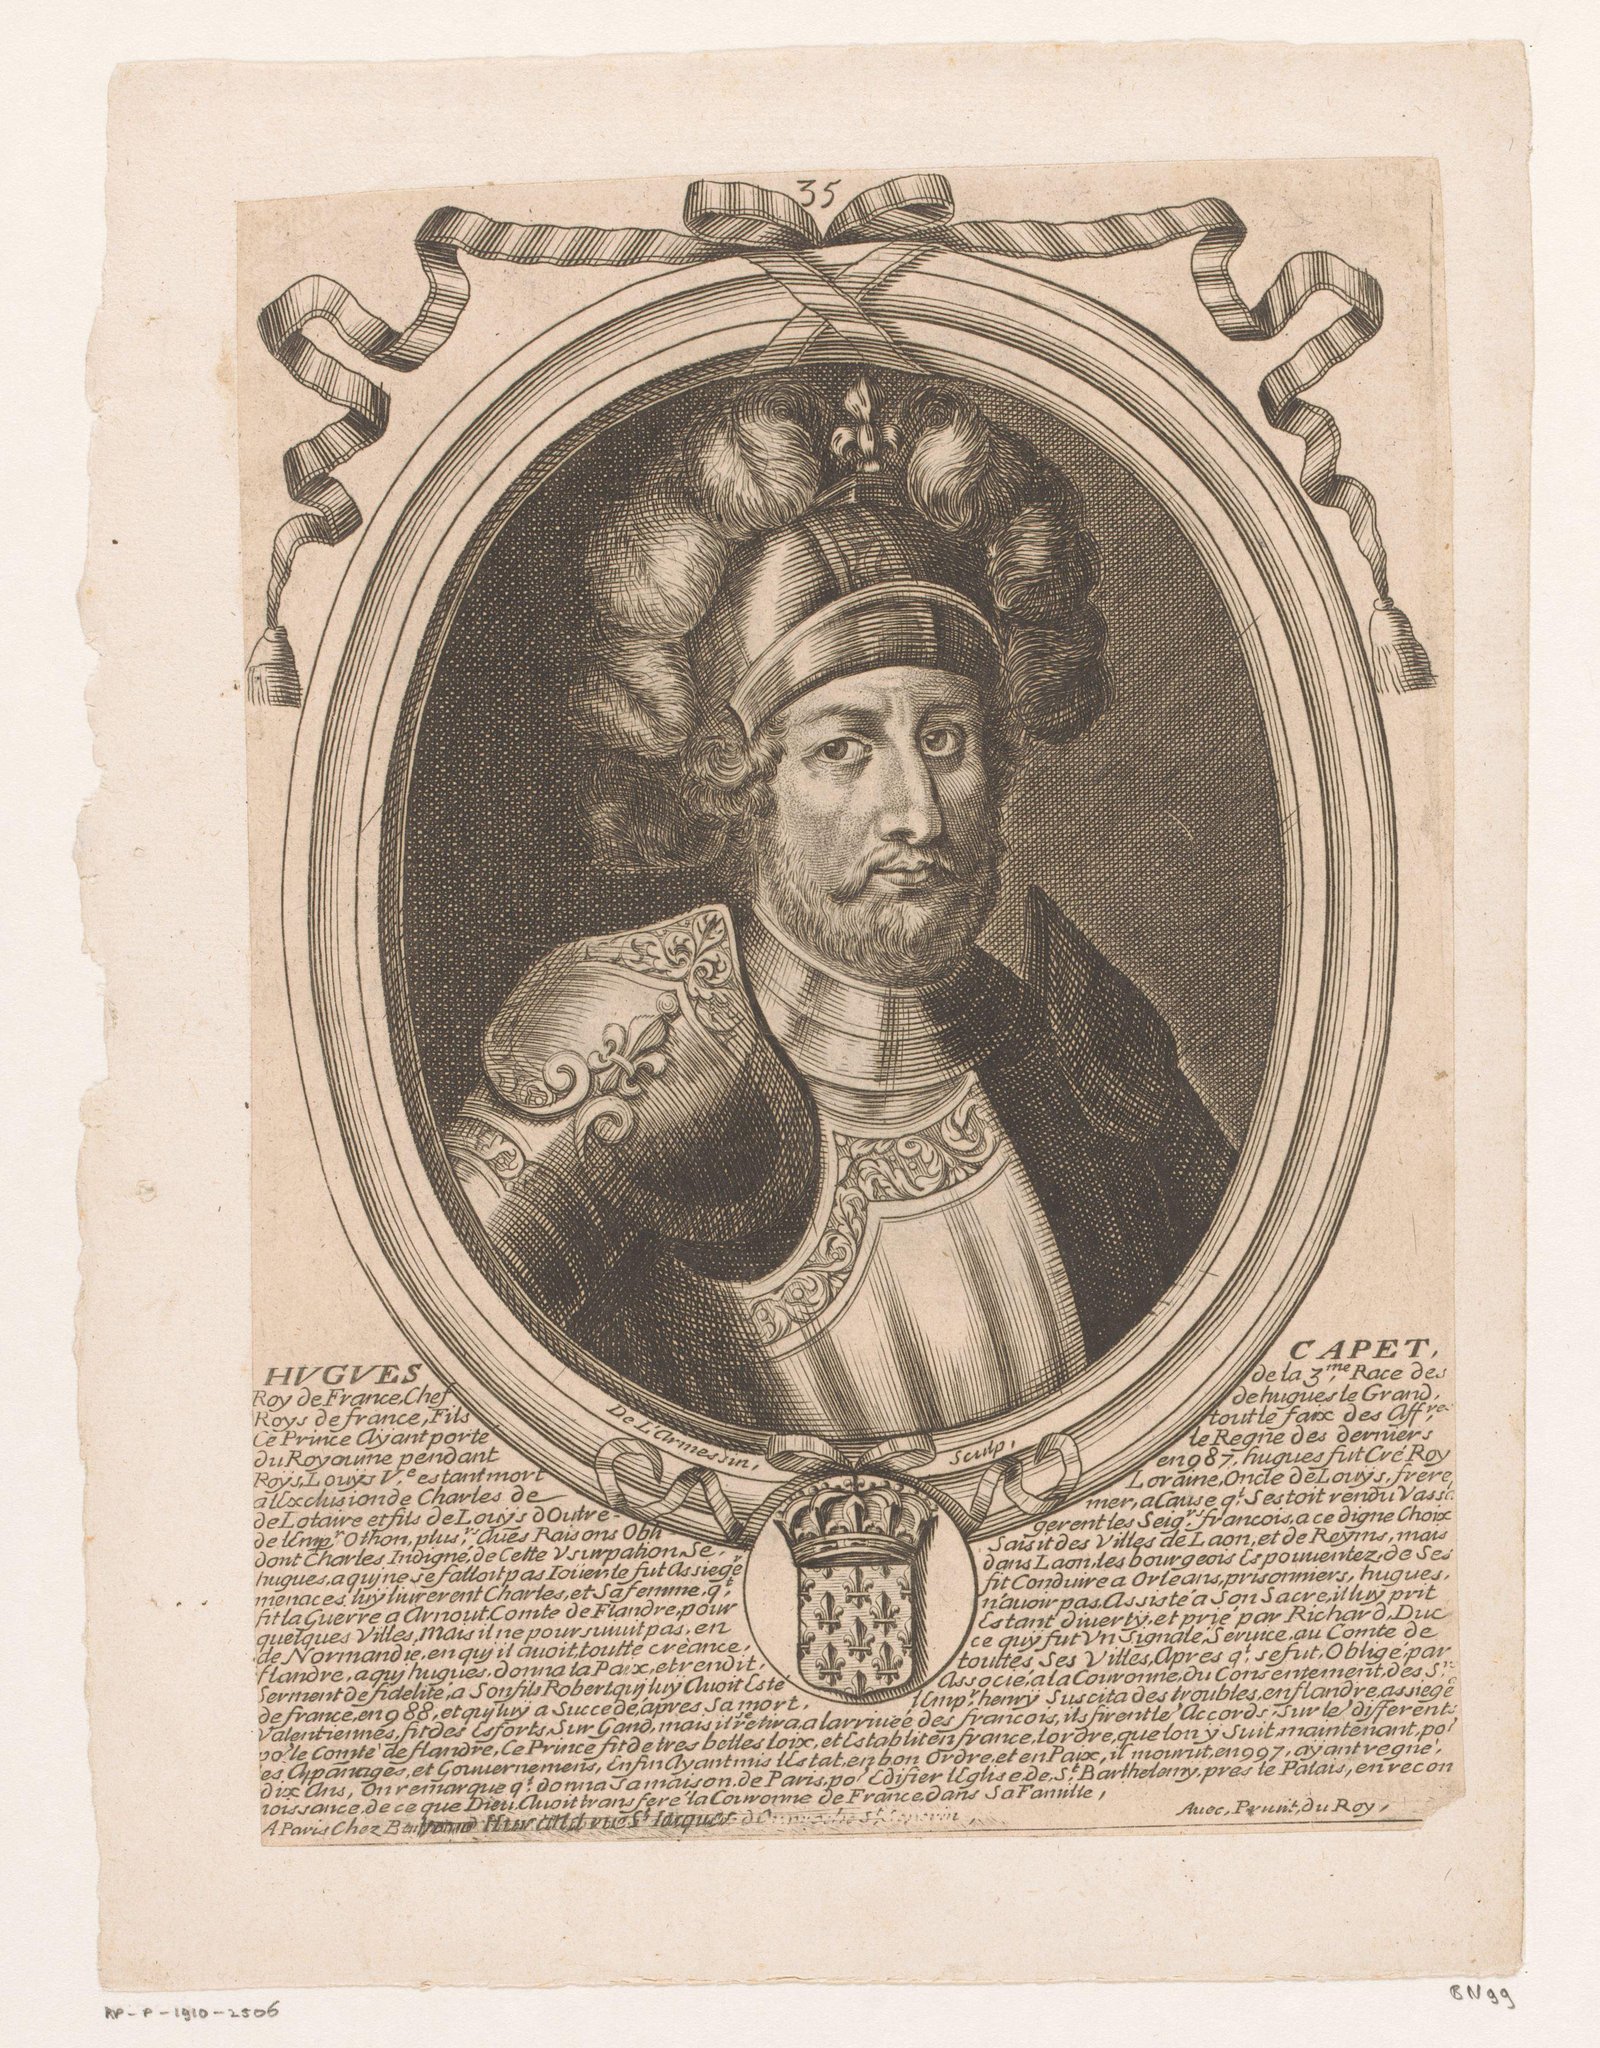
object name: print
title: Huges Capet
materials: paper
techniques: engraving, etching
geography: france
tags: historical persons, king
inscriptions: collector's mark: Lugt 2228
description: Maakt deel uit van een grootschalige serie met portretten van prominente figuren. Binnen de serie bevindt zich een sectie getiteld 'Les Augustes Représentations De tous les Roys De France depuis Pharamond Iusqu'à Louys XIIII'. De serie werd respectievelijk uitgegeven door Pierre Bertrand, door zijn weduwe en door De Larmessin zelf.